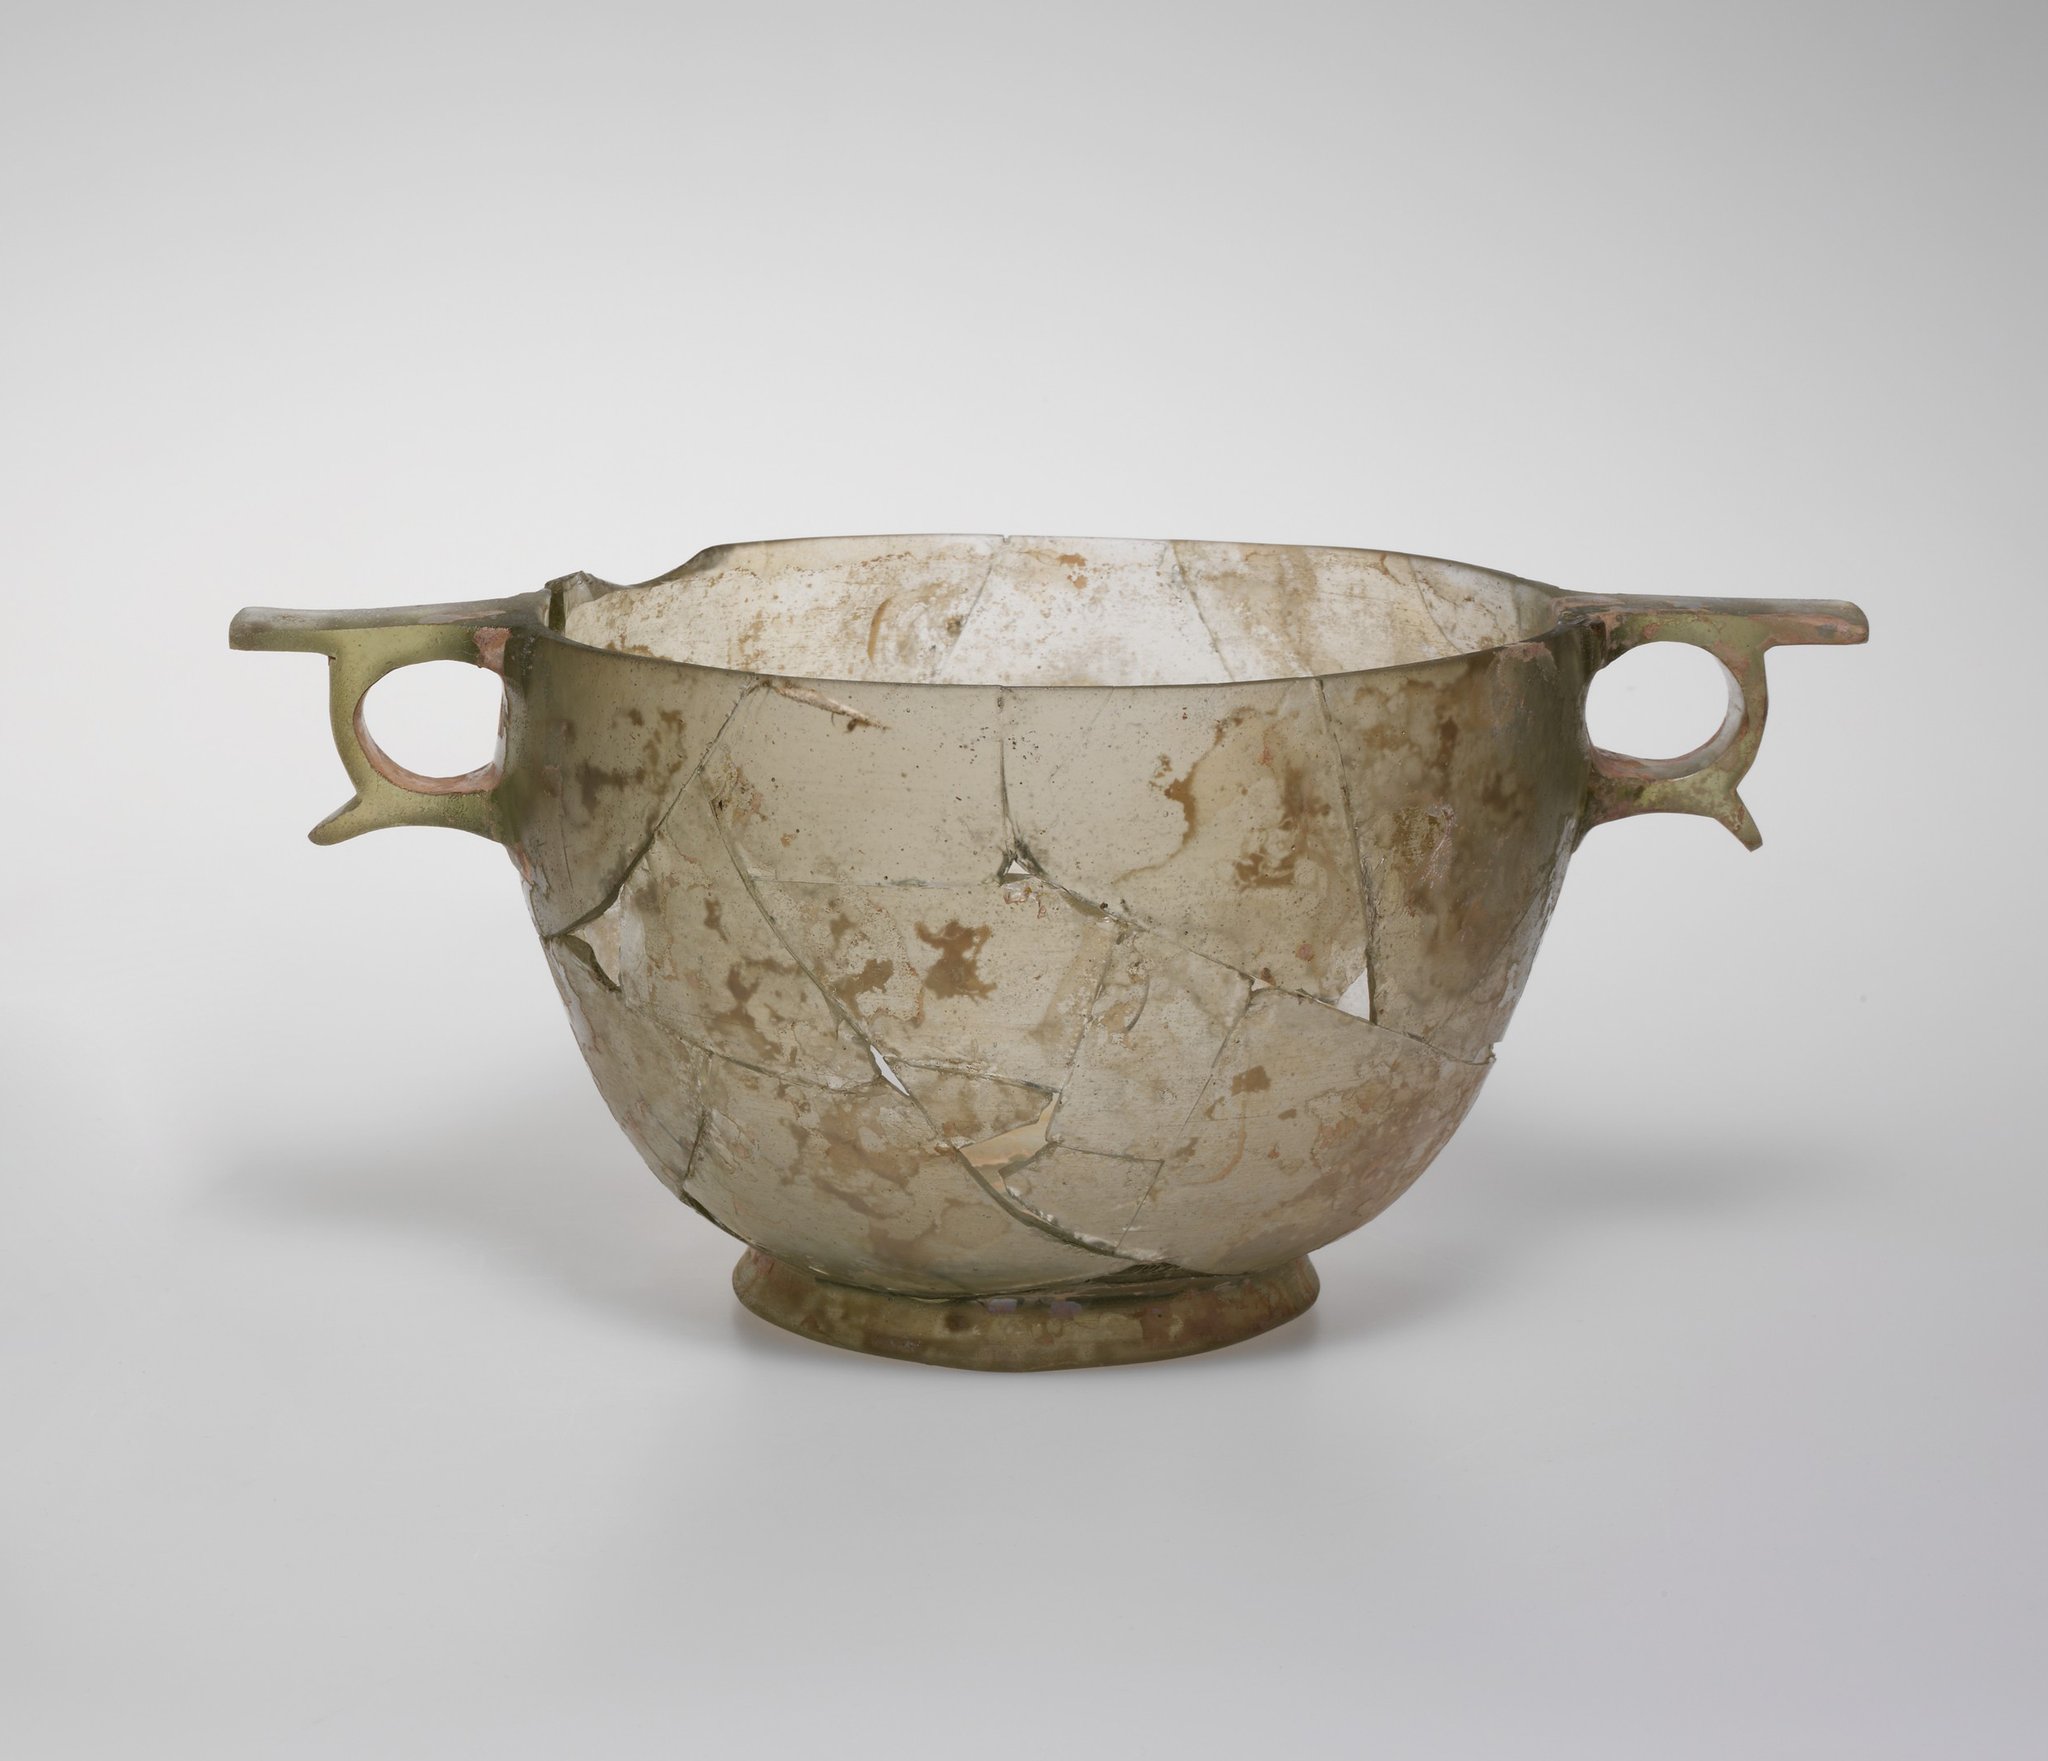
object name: skyphos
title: Glass skyphos (drinking cup)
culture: greek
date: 234-168 BCE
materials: glass